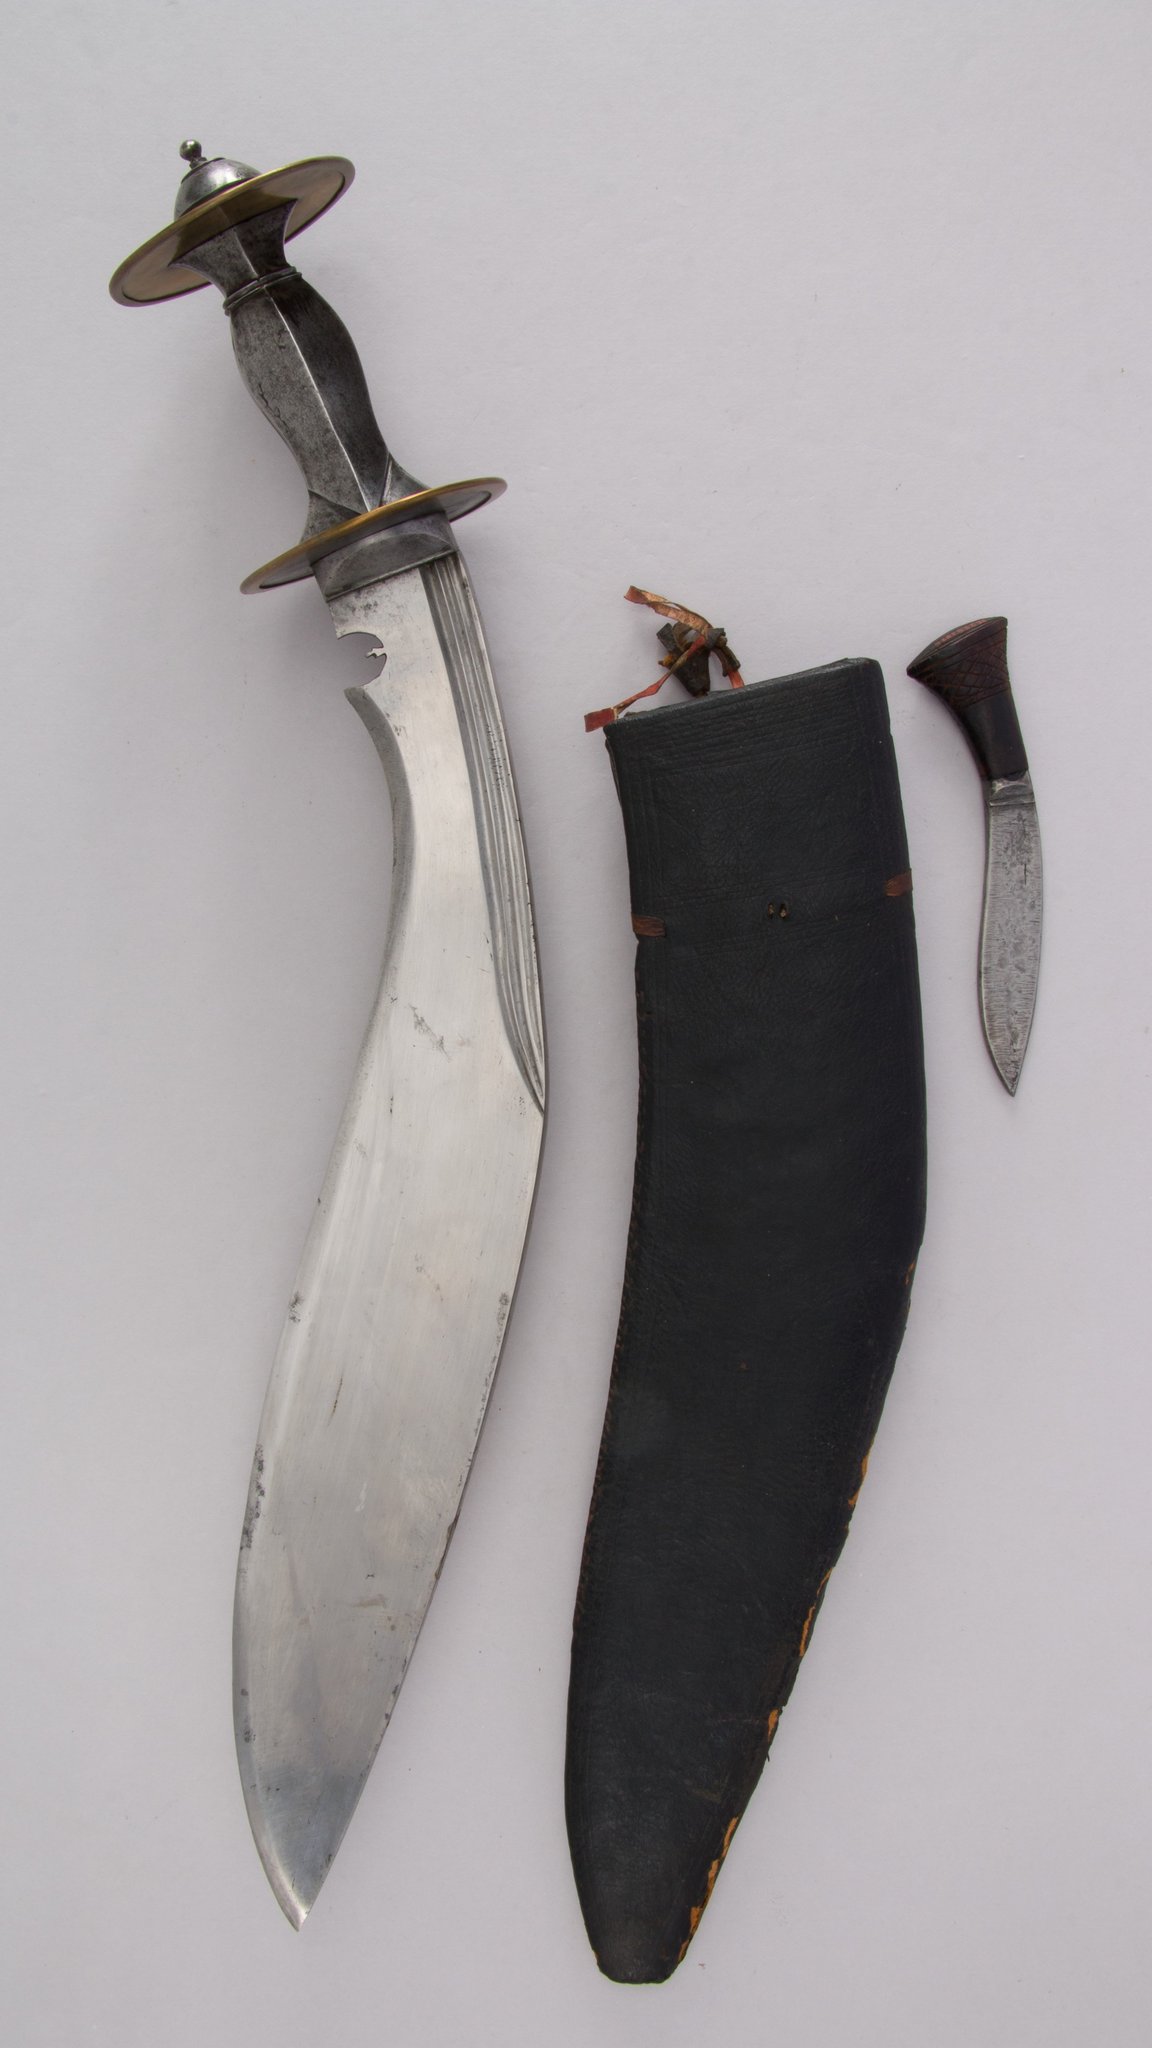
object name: knife kukri with sheath, two small knife and pouch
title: Knife (Kukri) with Sheath, Small Knife and Pouch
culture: gurkha or indian or nepalese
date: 1801-1900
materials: leather, steel, wood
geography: india